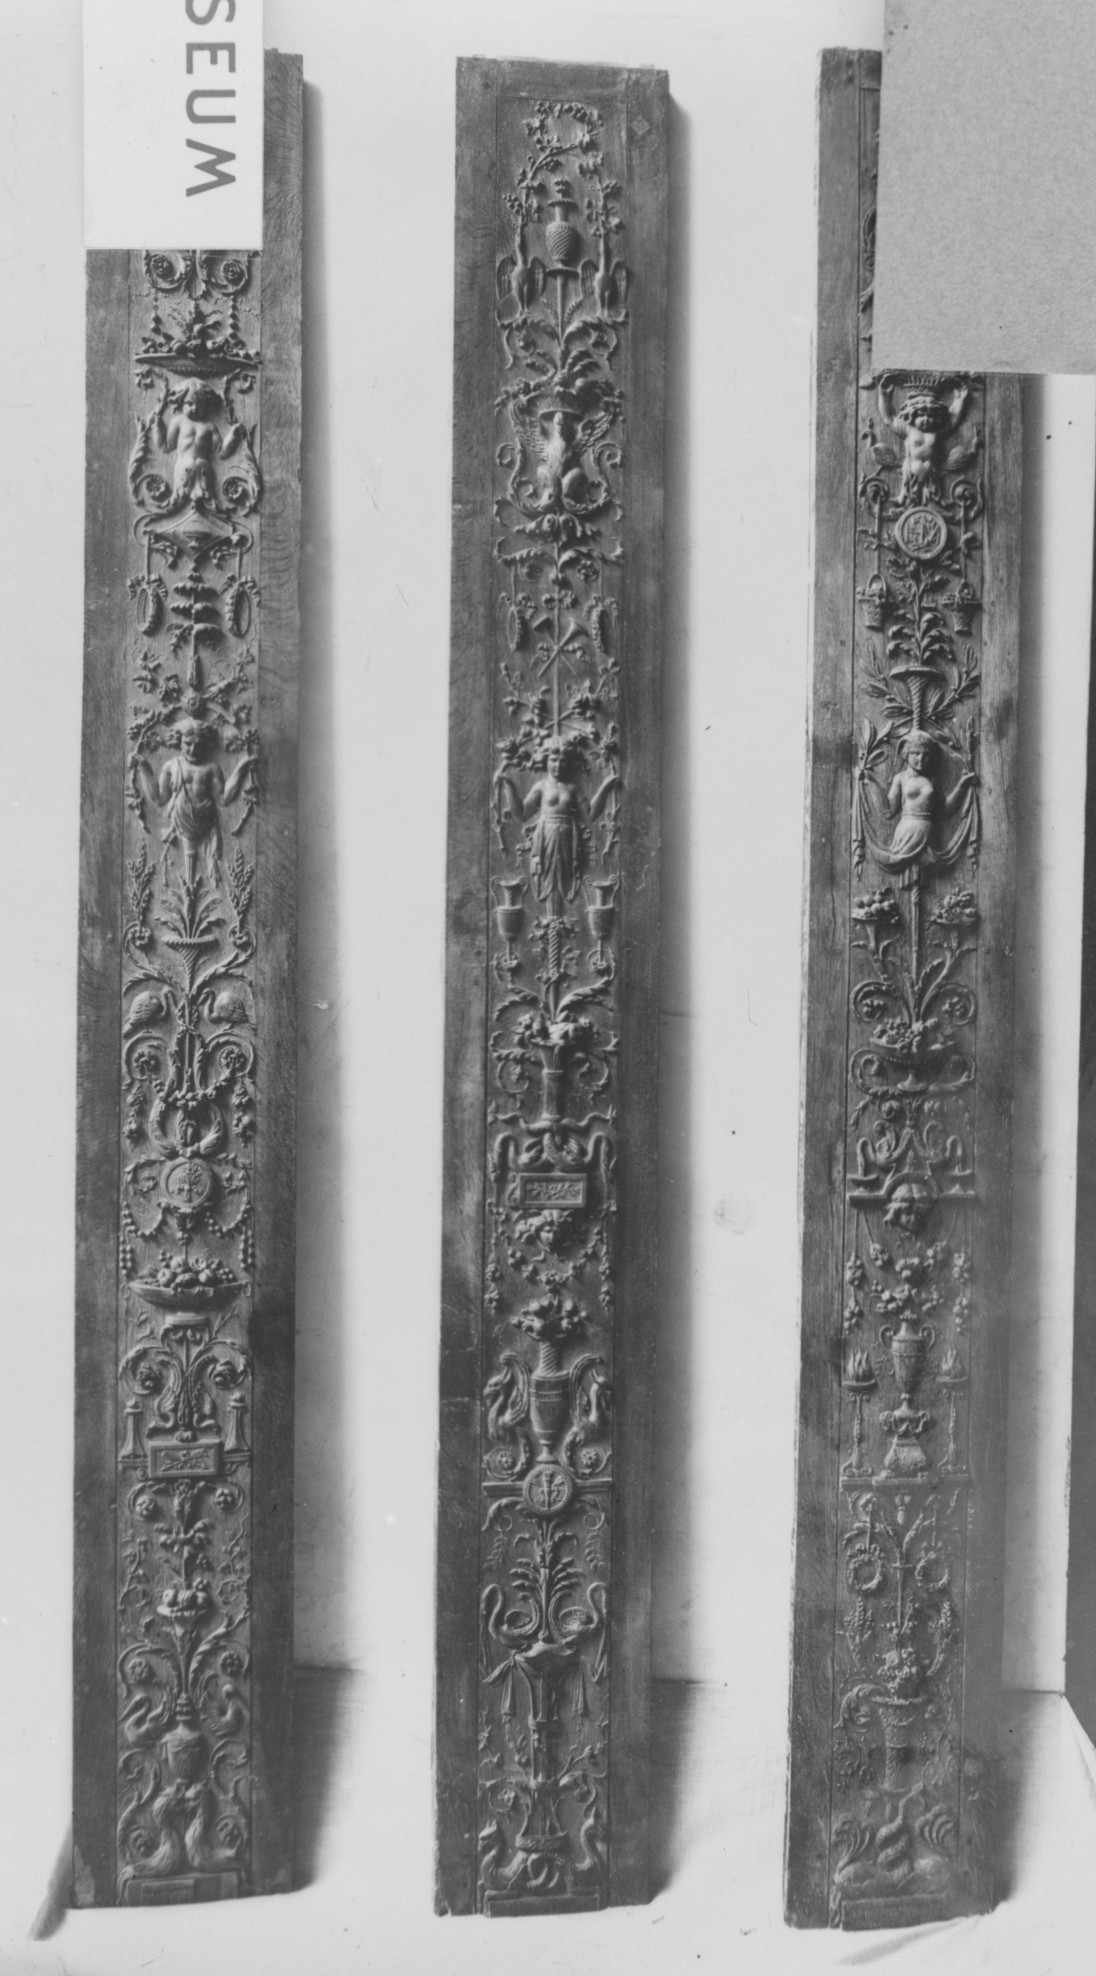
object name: pilaster panel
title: Pilaster panel (part of a set of eight)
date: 1701-1800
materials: wood